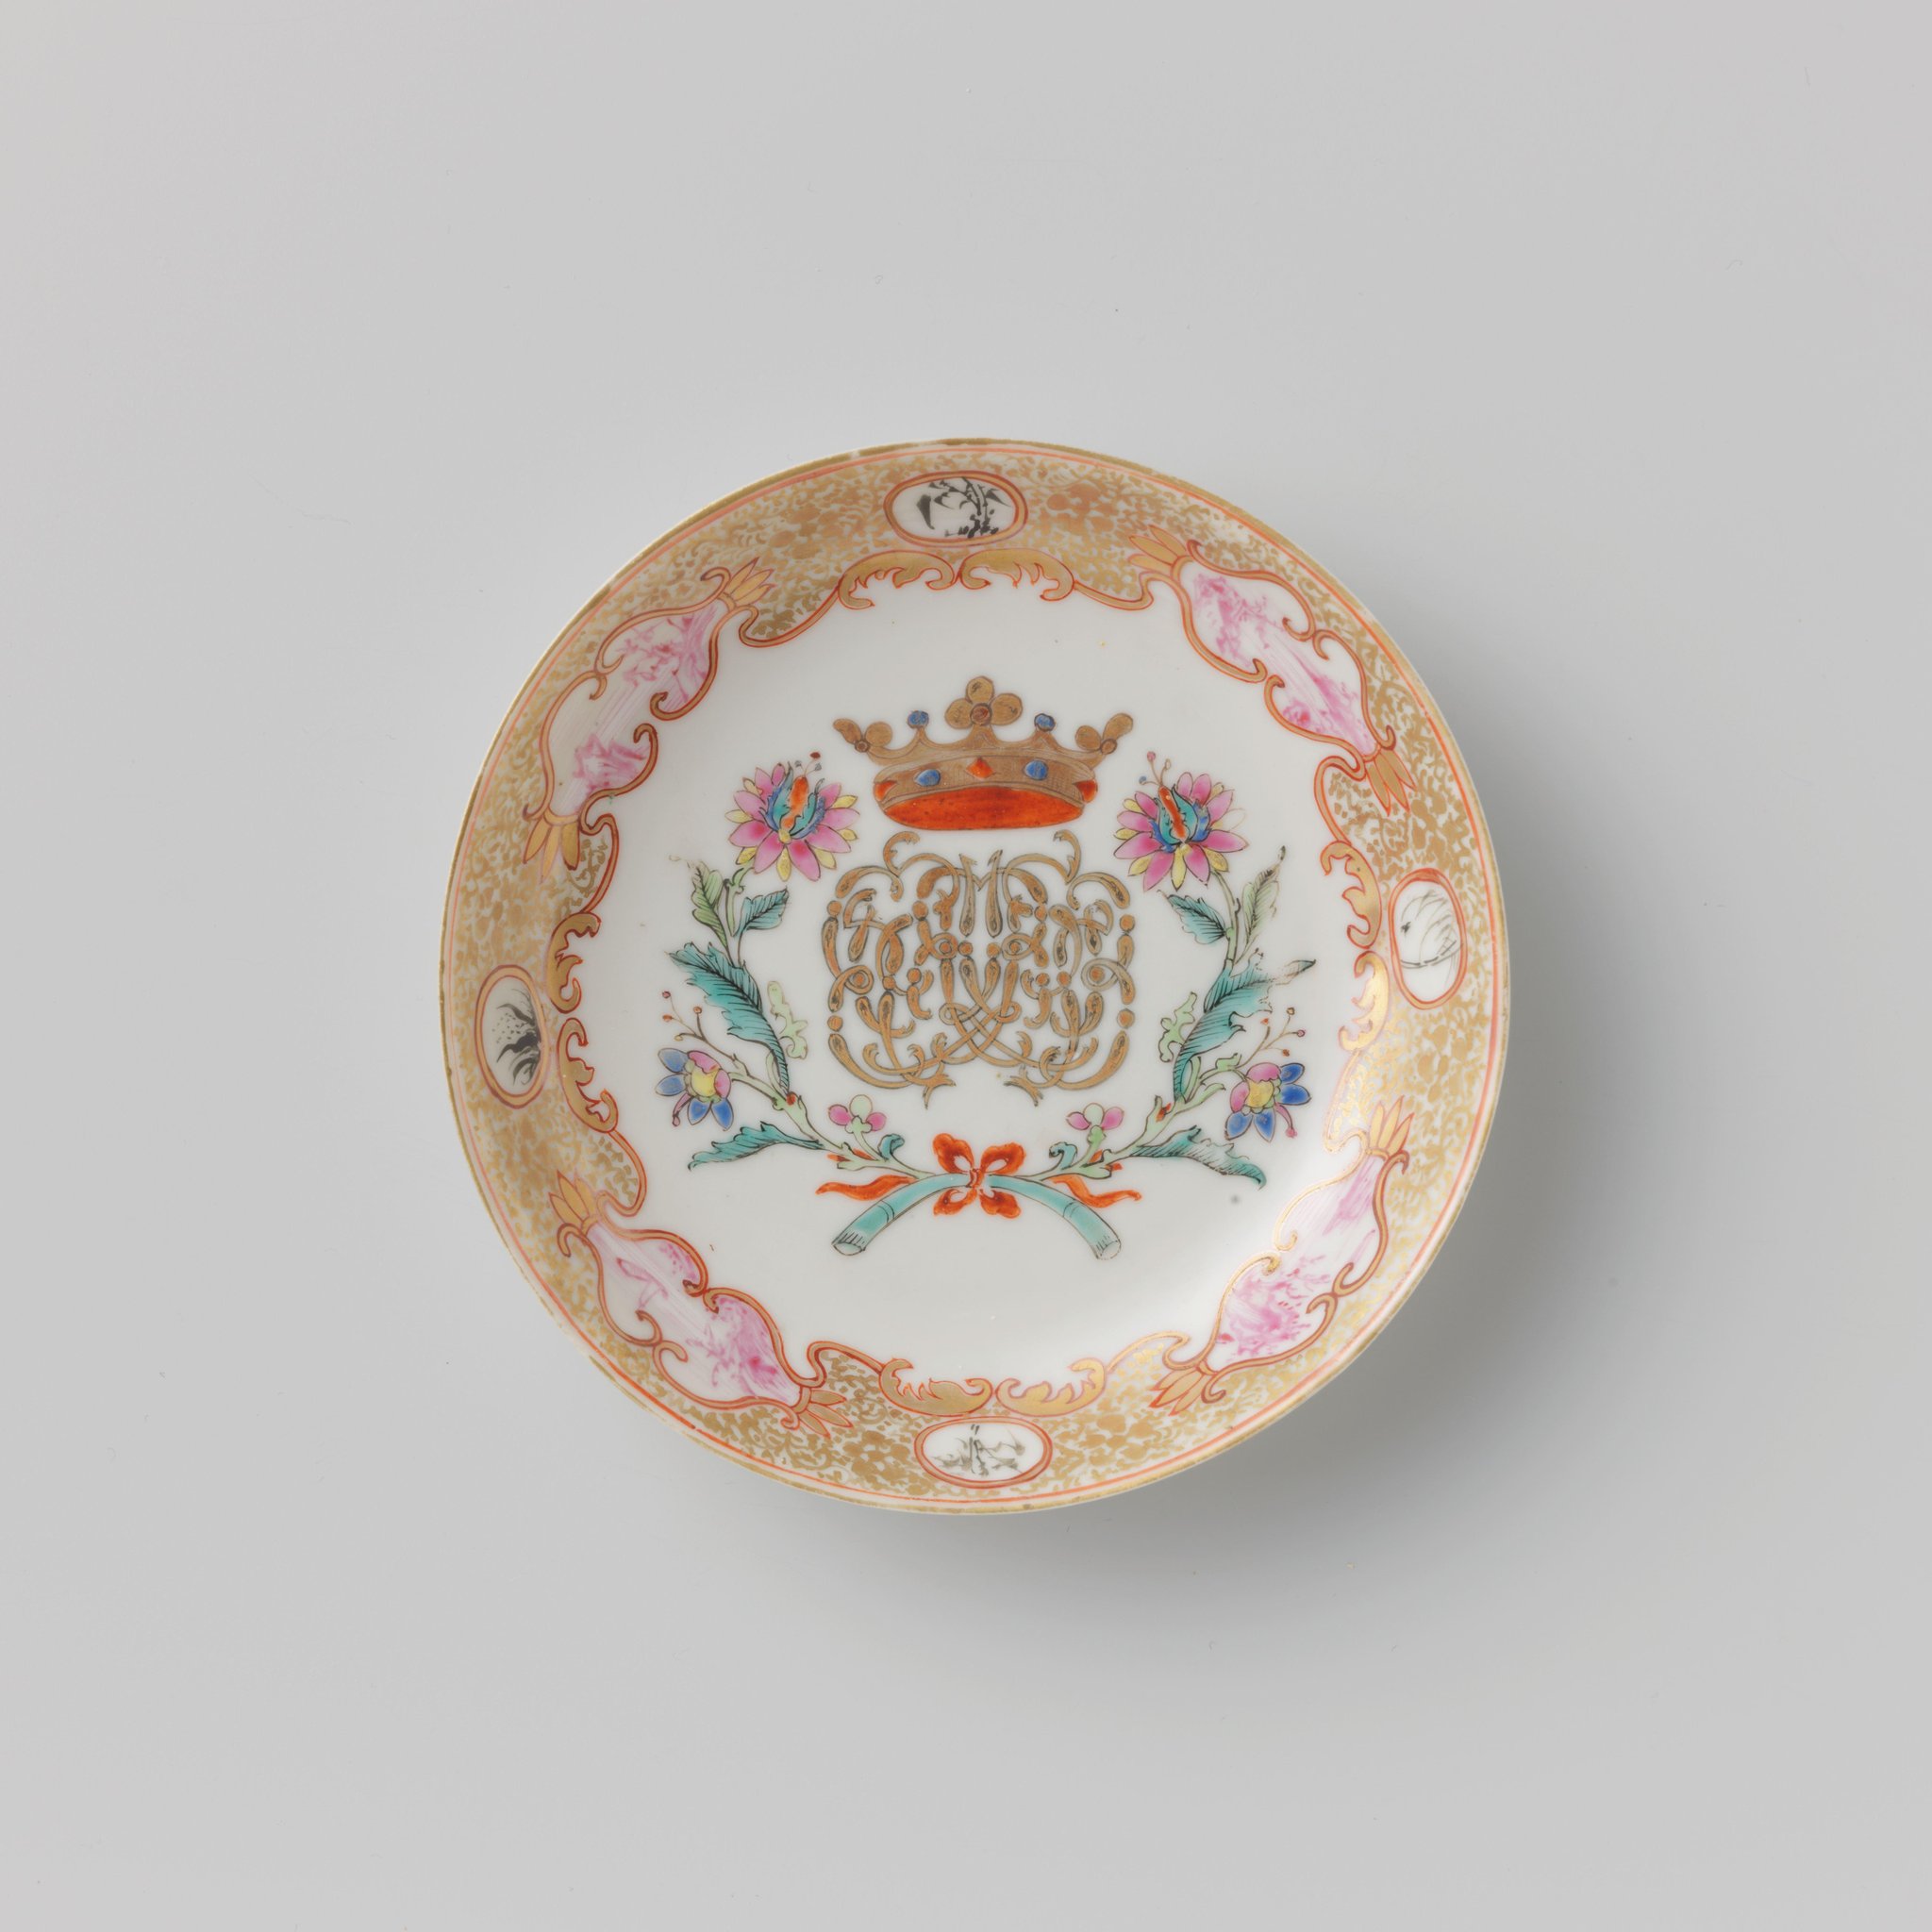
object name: platter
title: Saucer with a crowned, illegible monogram surrounded by two flower sprays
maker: Anonymous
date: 1750-1774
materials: glaze, gold, paint, porcelain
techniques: firing, gilding, turning, vitrification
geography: china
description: Schotel van porselein, beschilderd op het glazuur in blauw, rood, roze, groen, geel, zwart en goud. Op het plat een gekroond, onleesbaar monogram omringd door twee bloemtakken; de wand met bloemranken met daarin uitgespaard vier cartouches met een landschap en vier medaillons met planten. Europese voorstelling in emailkleuren.